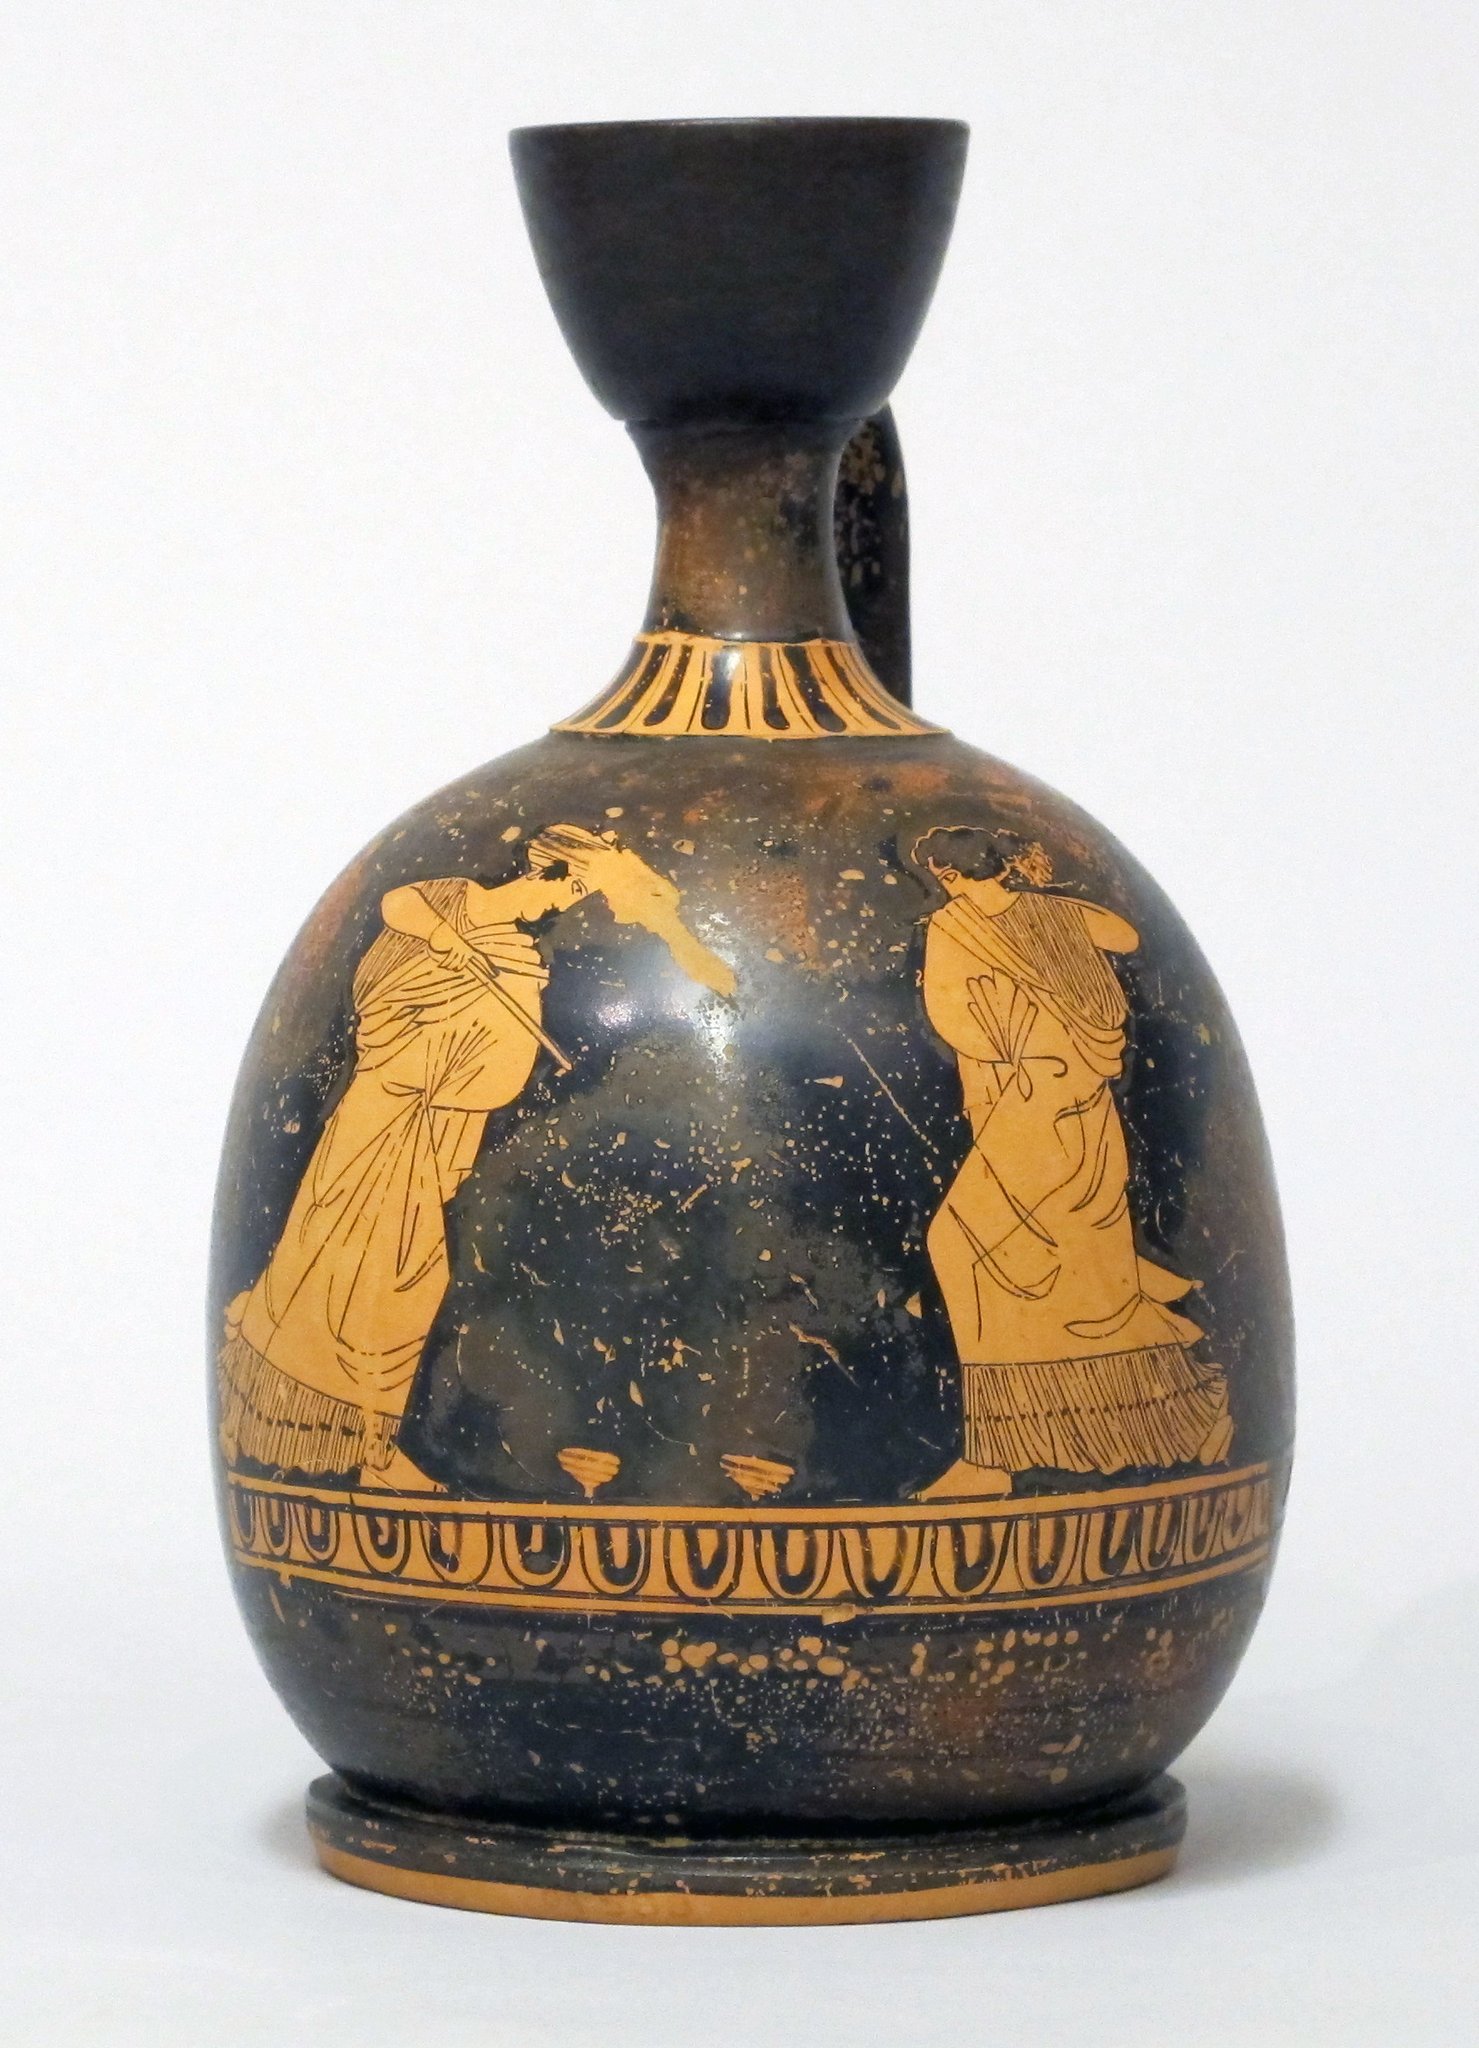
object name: squat lekythos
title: Terracotta squat lekythos (oil flask)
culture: greek, attic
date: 450-430 BCE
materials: terracotta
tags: women